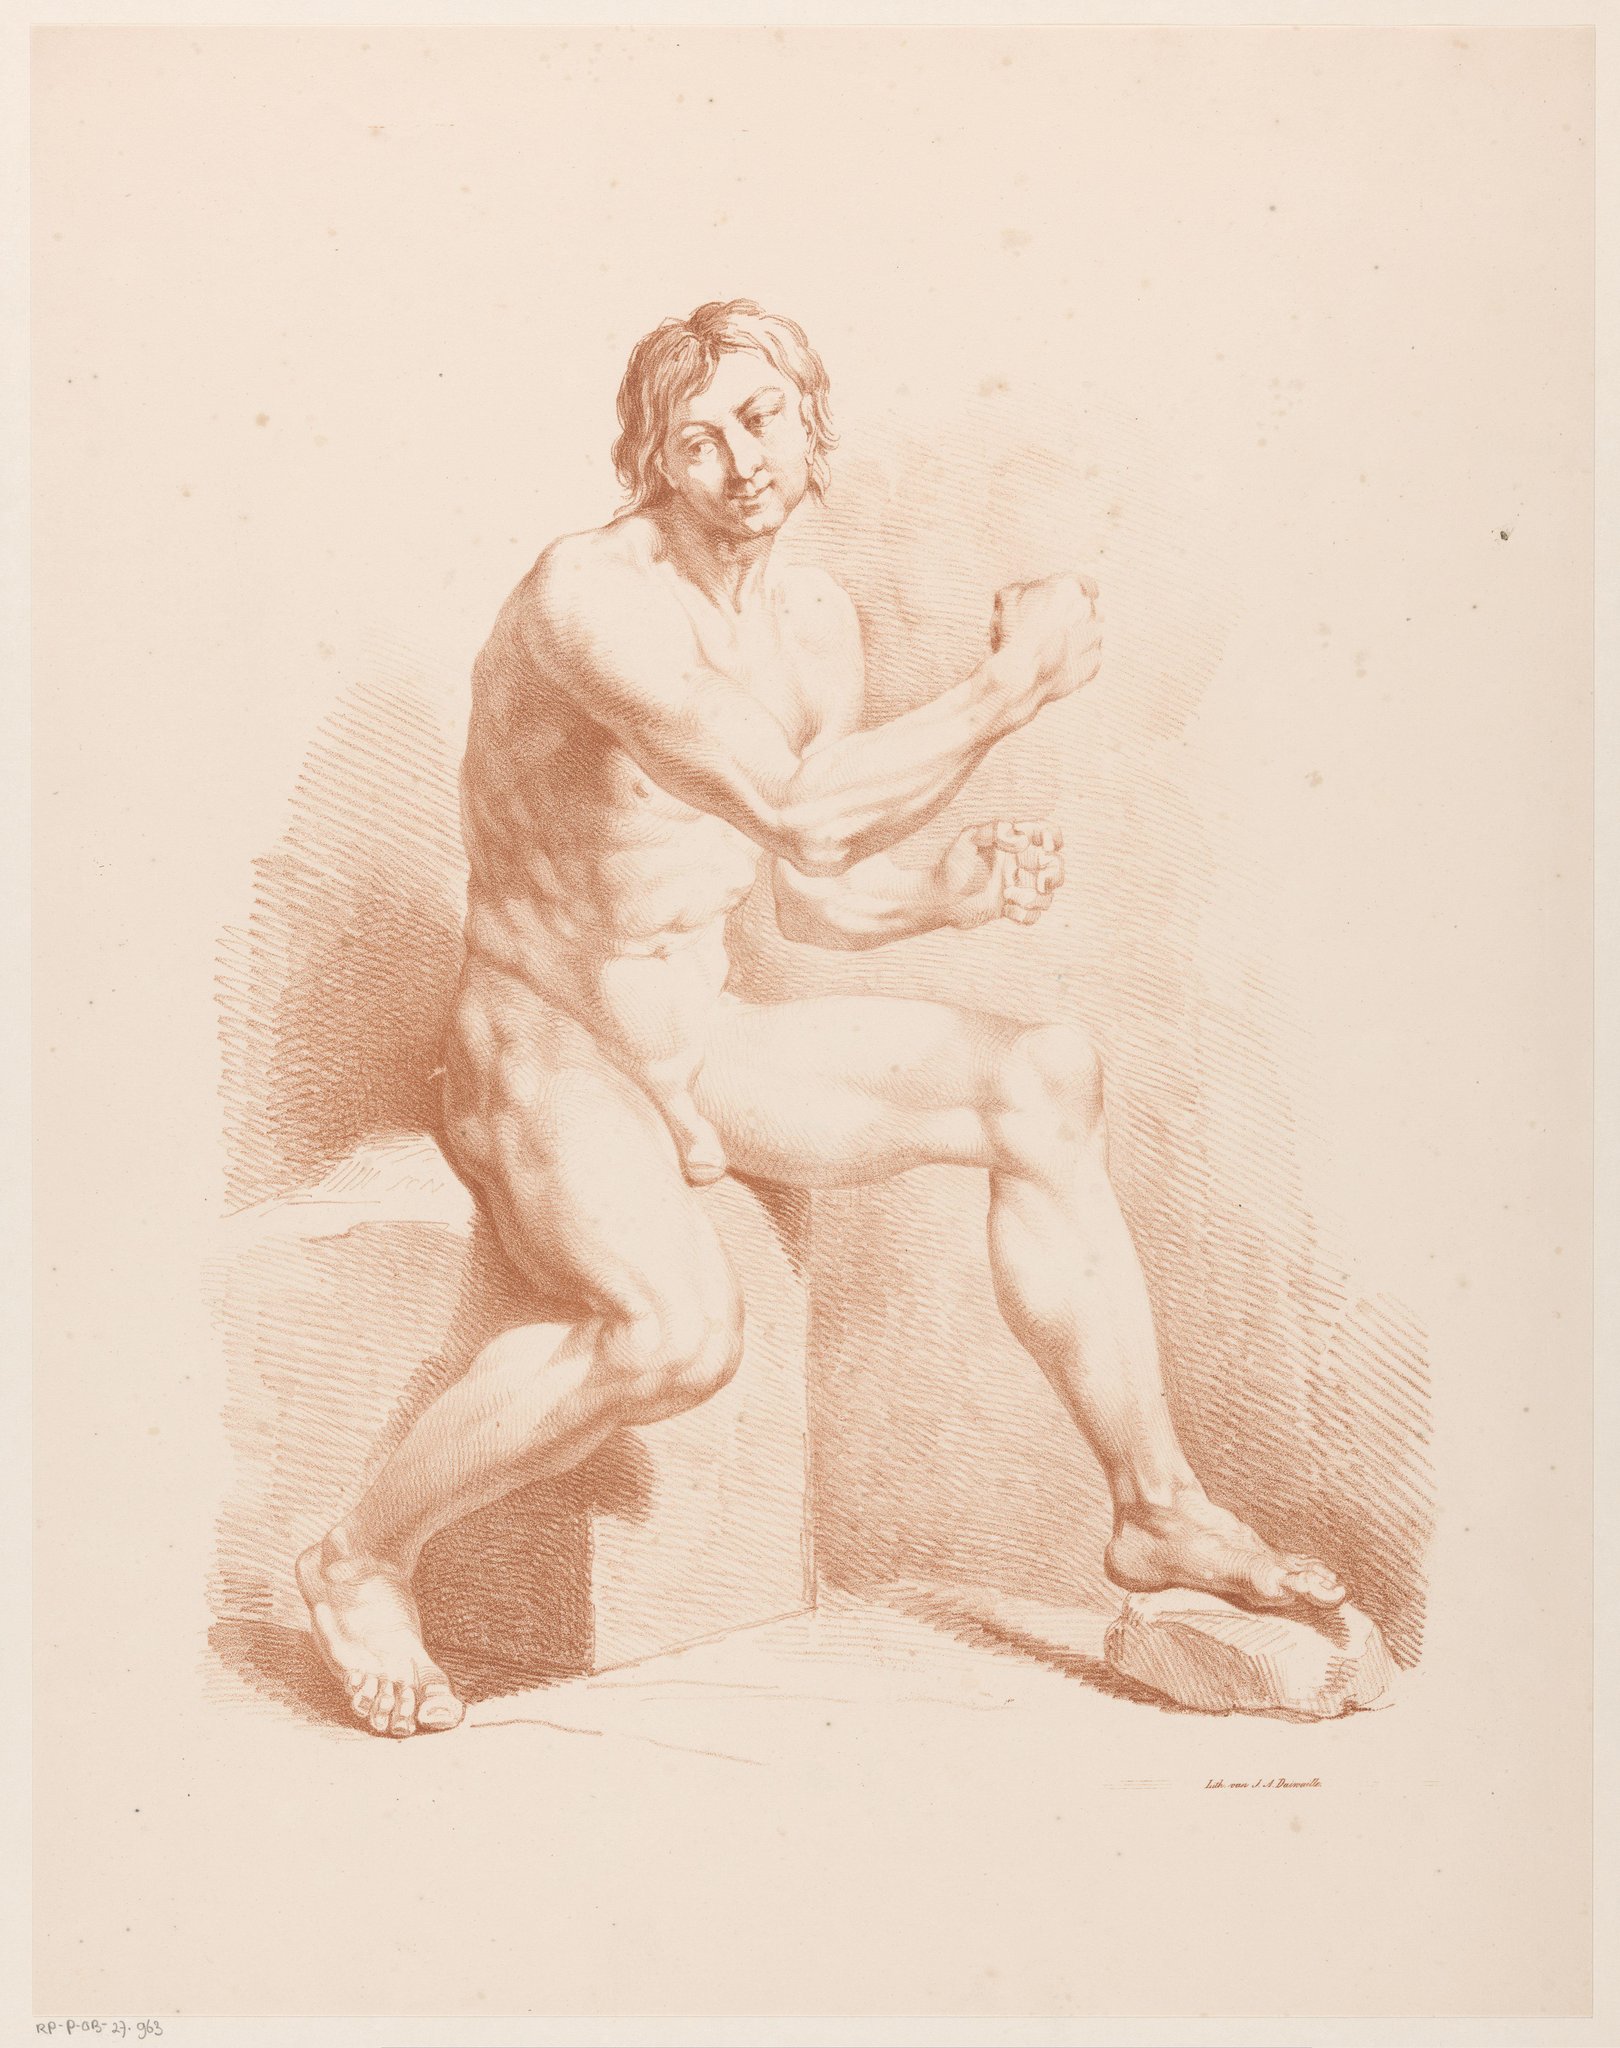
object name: print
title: Zittende naakte man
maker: jean augustin daiwaille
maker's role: draughtsman, print maker, printer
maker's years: 1786-1850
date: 1820-1833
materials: paper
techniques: lithograph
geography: amsterdam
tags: the (nude) human figure; 'corpo humano' (ripa), sitting on an elevation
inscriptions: collector's mark: Lugt 2228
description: De man zit op een blok en houdt zijn handen boven elkaar en voor zich uitgestrekt. Hij kijkt naar linksonder.